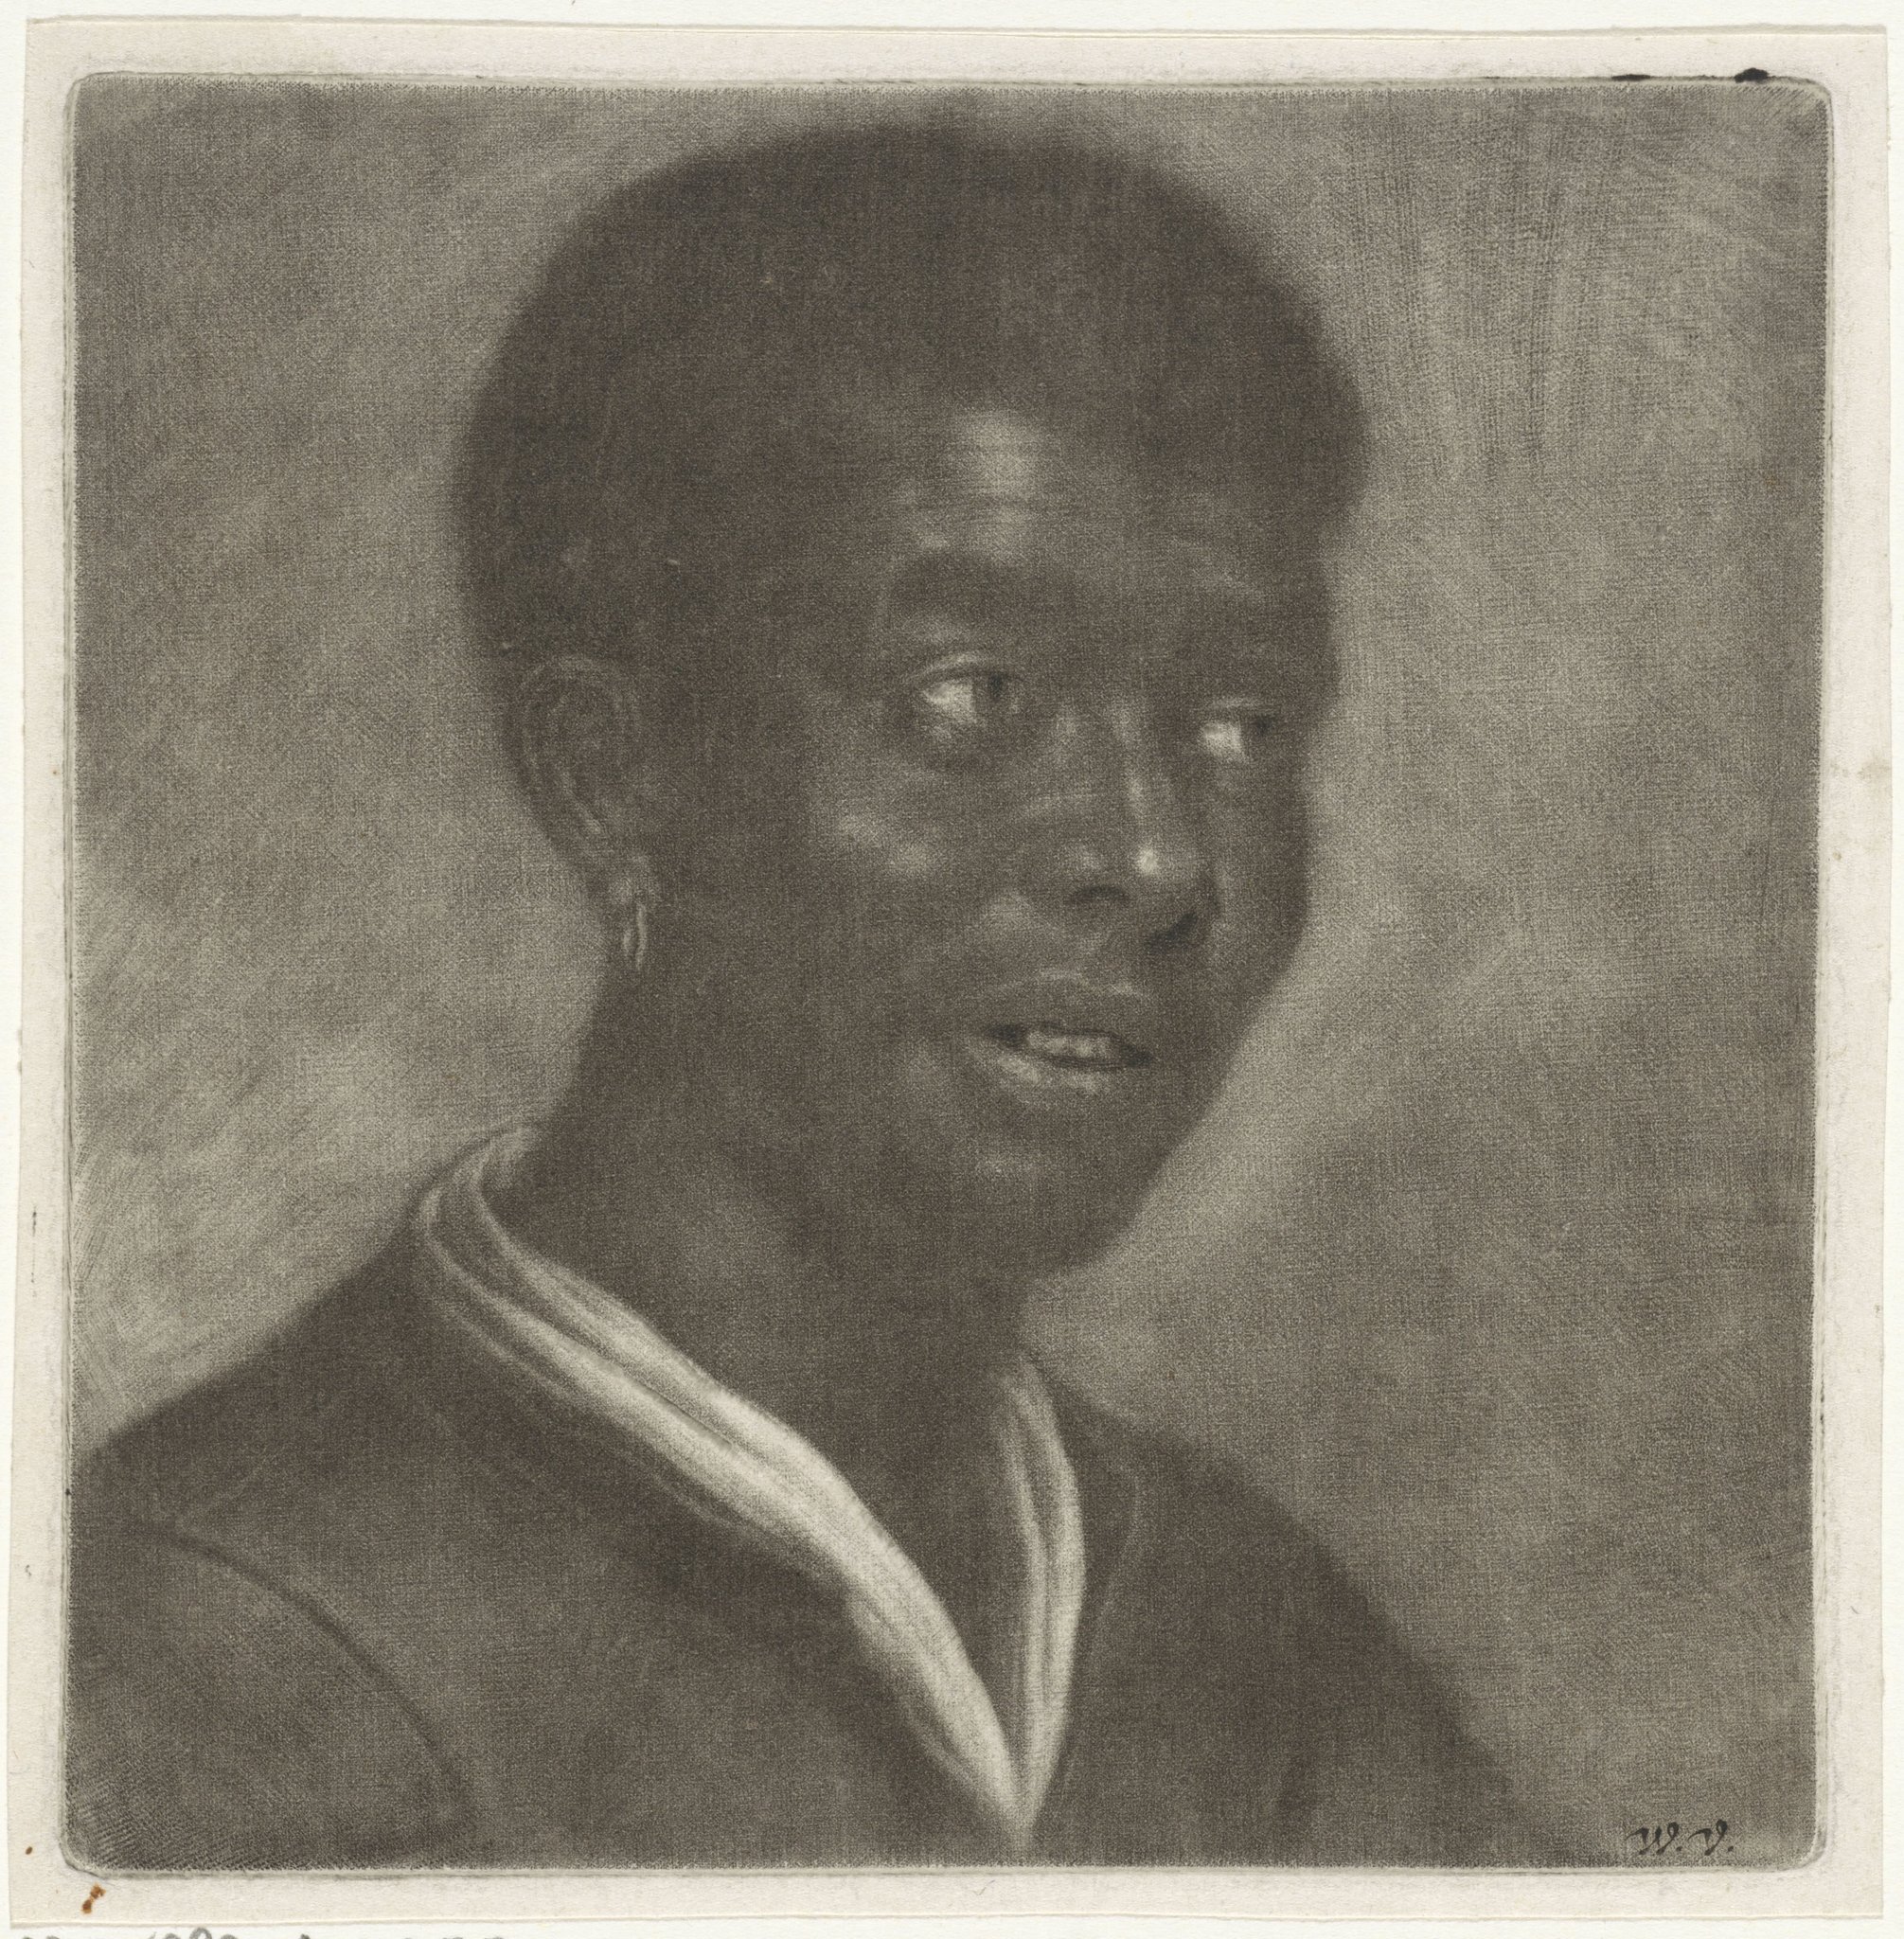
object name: print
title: Buste van een donkere man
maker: wallerant vaillant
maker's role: draughtsman, painter, print maker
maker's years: 1623-1677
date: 1658-1677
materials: paper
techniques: mezzotint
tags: africans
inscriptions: collector's mark: Lugt 2228